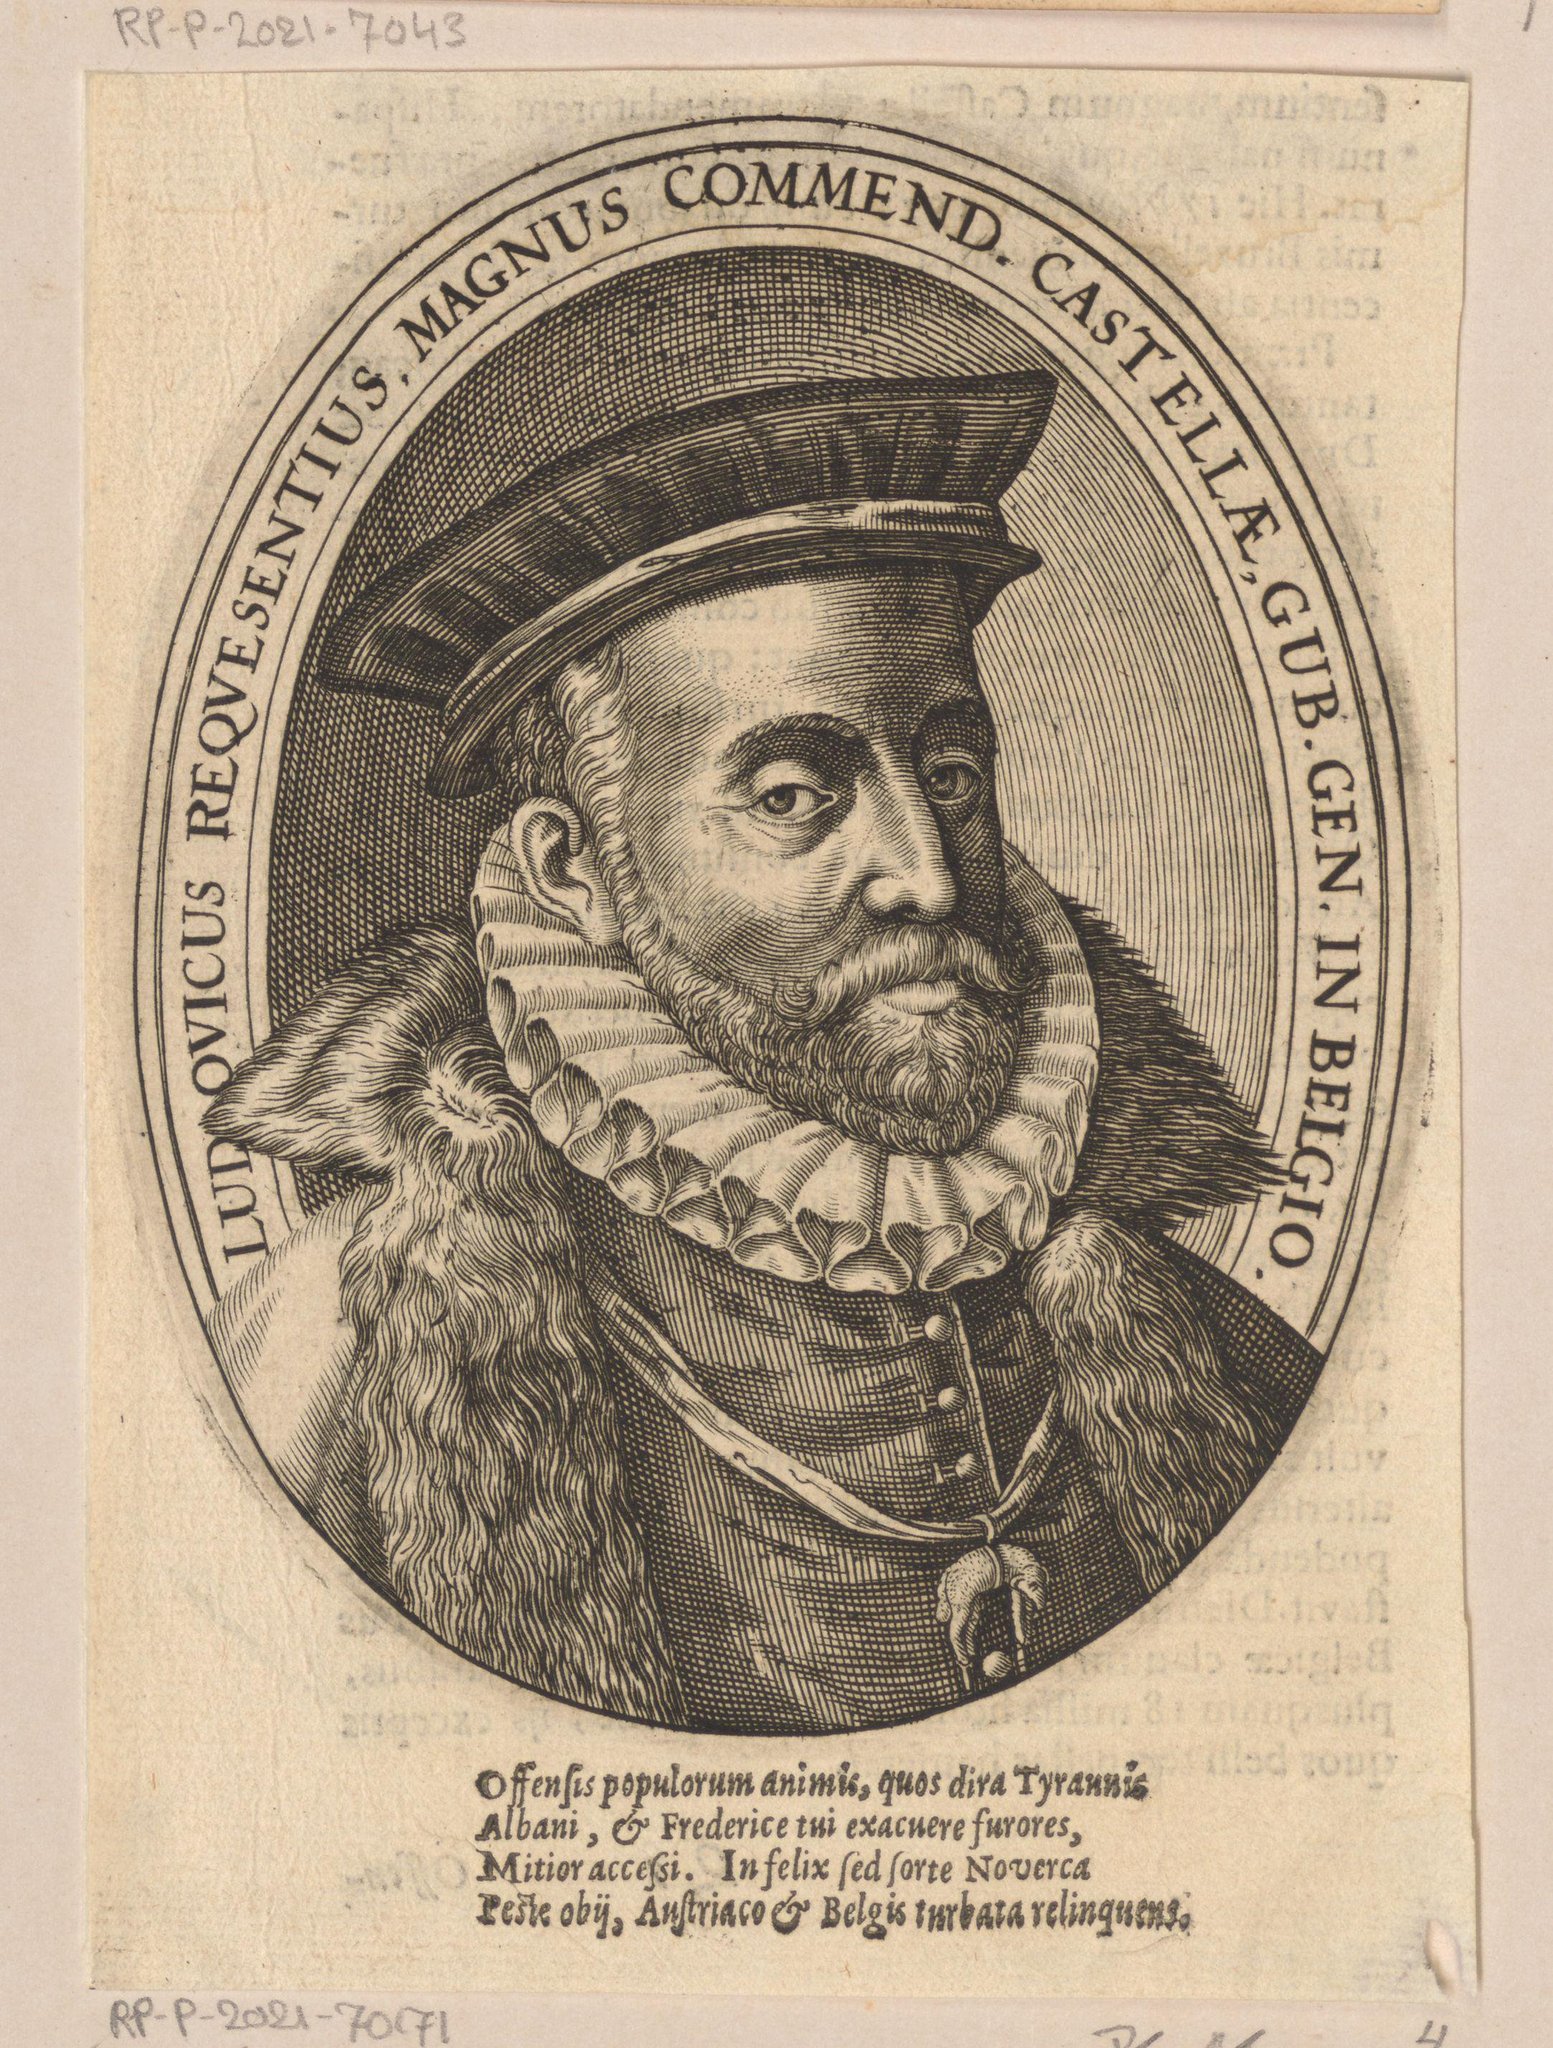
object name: book illustration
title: Portret van Luis de Zúñiga y Requesens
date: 1619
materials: paper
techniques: engraving, letterpress printing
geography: leiden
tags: brussels, mayor, luis de zúñiga y requesens, historical persons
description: Prent uit: Gysius, Johannes. Origo & historia Belgicorum tumultuum immanissimaeque crudelitatis per Cliviam & VVestphaliam (...). Leiden: Bartholomeus van der Bildt, 1619.